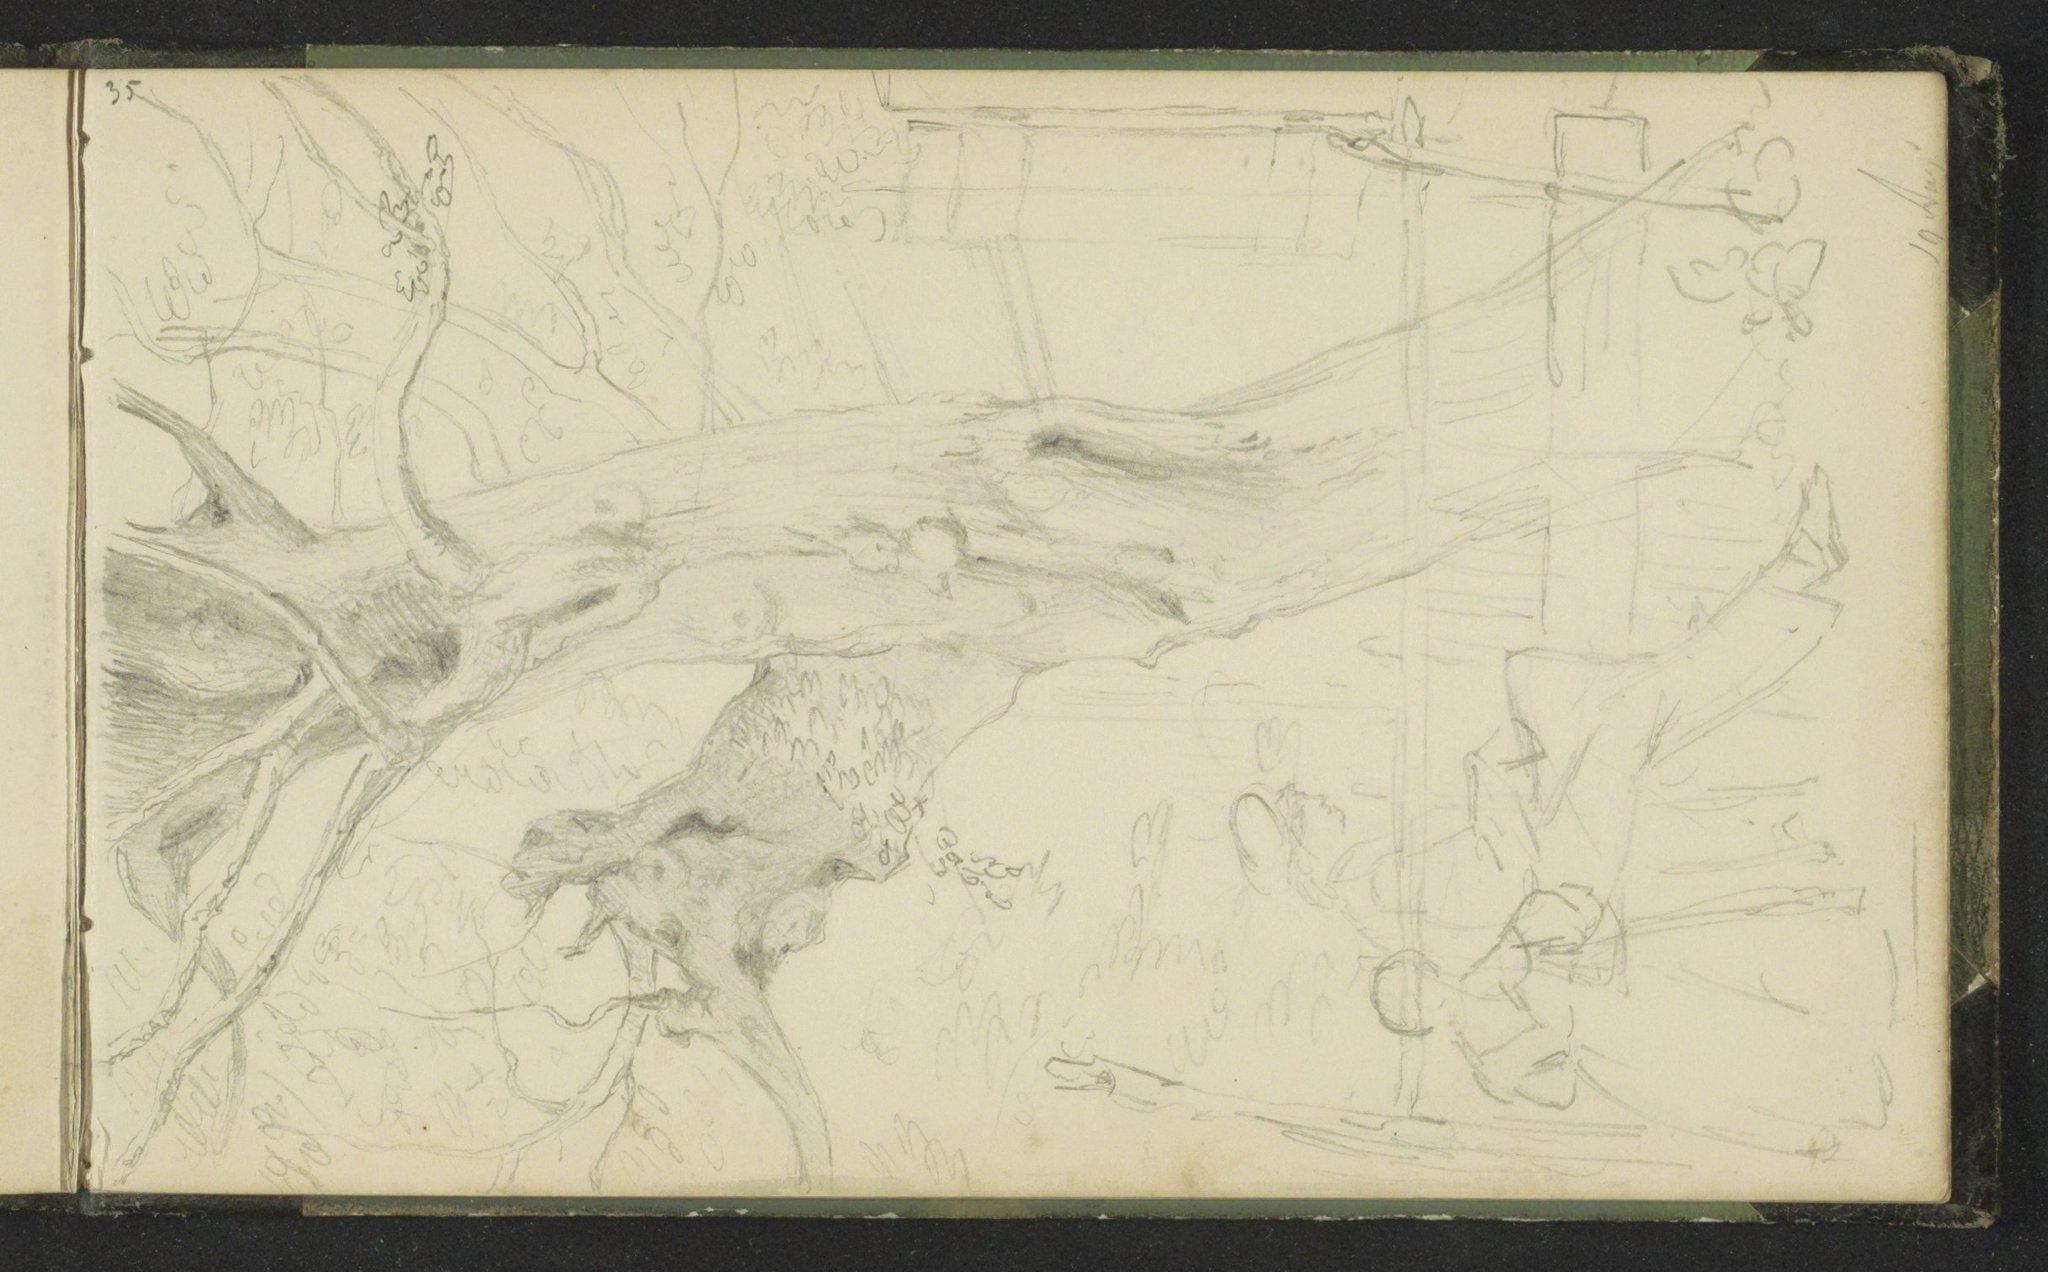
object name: sketchbook leaf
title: Twee figuren onder een boom in een tuin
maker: hendrik abraham klinkhamer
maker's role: draughtsman, painter, print maker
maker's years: 1810-1872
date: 1808-1843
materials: paper, pencil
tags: trees, garden, fence, wall, paling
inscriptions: date: ‘19 Aug’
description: Blad 35 recto uit een schetsboek met 40 bladen.